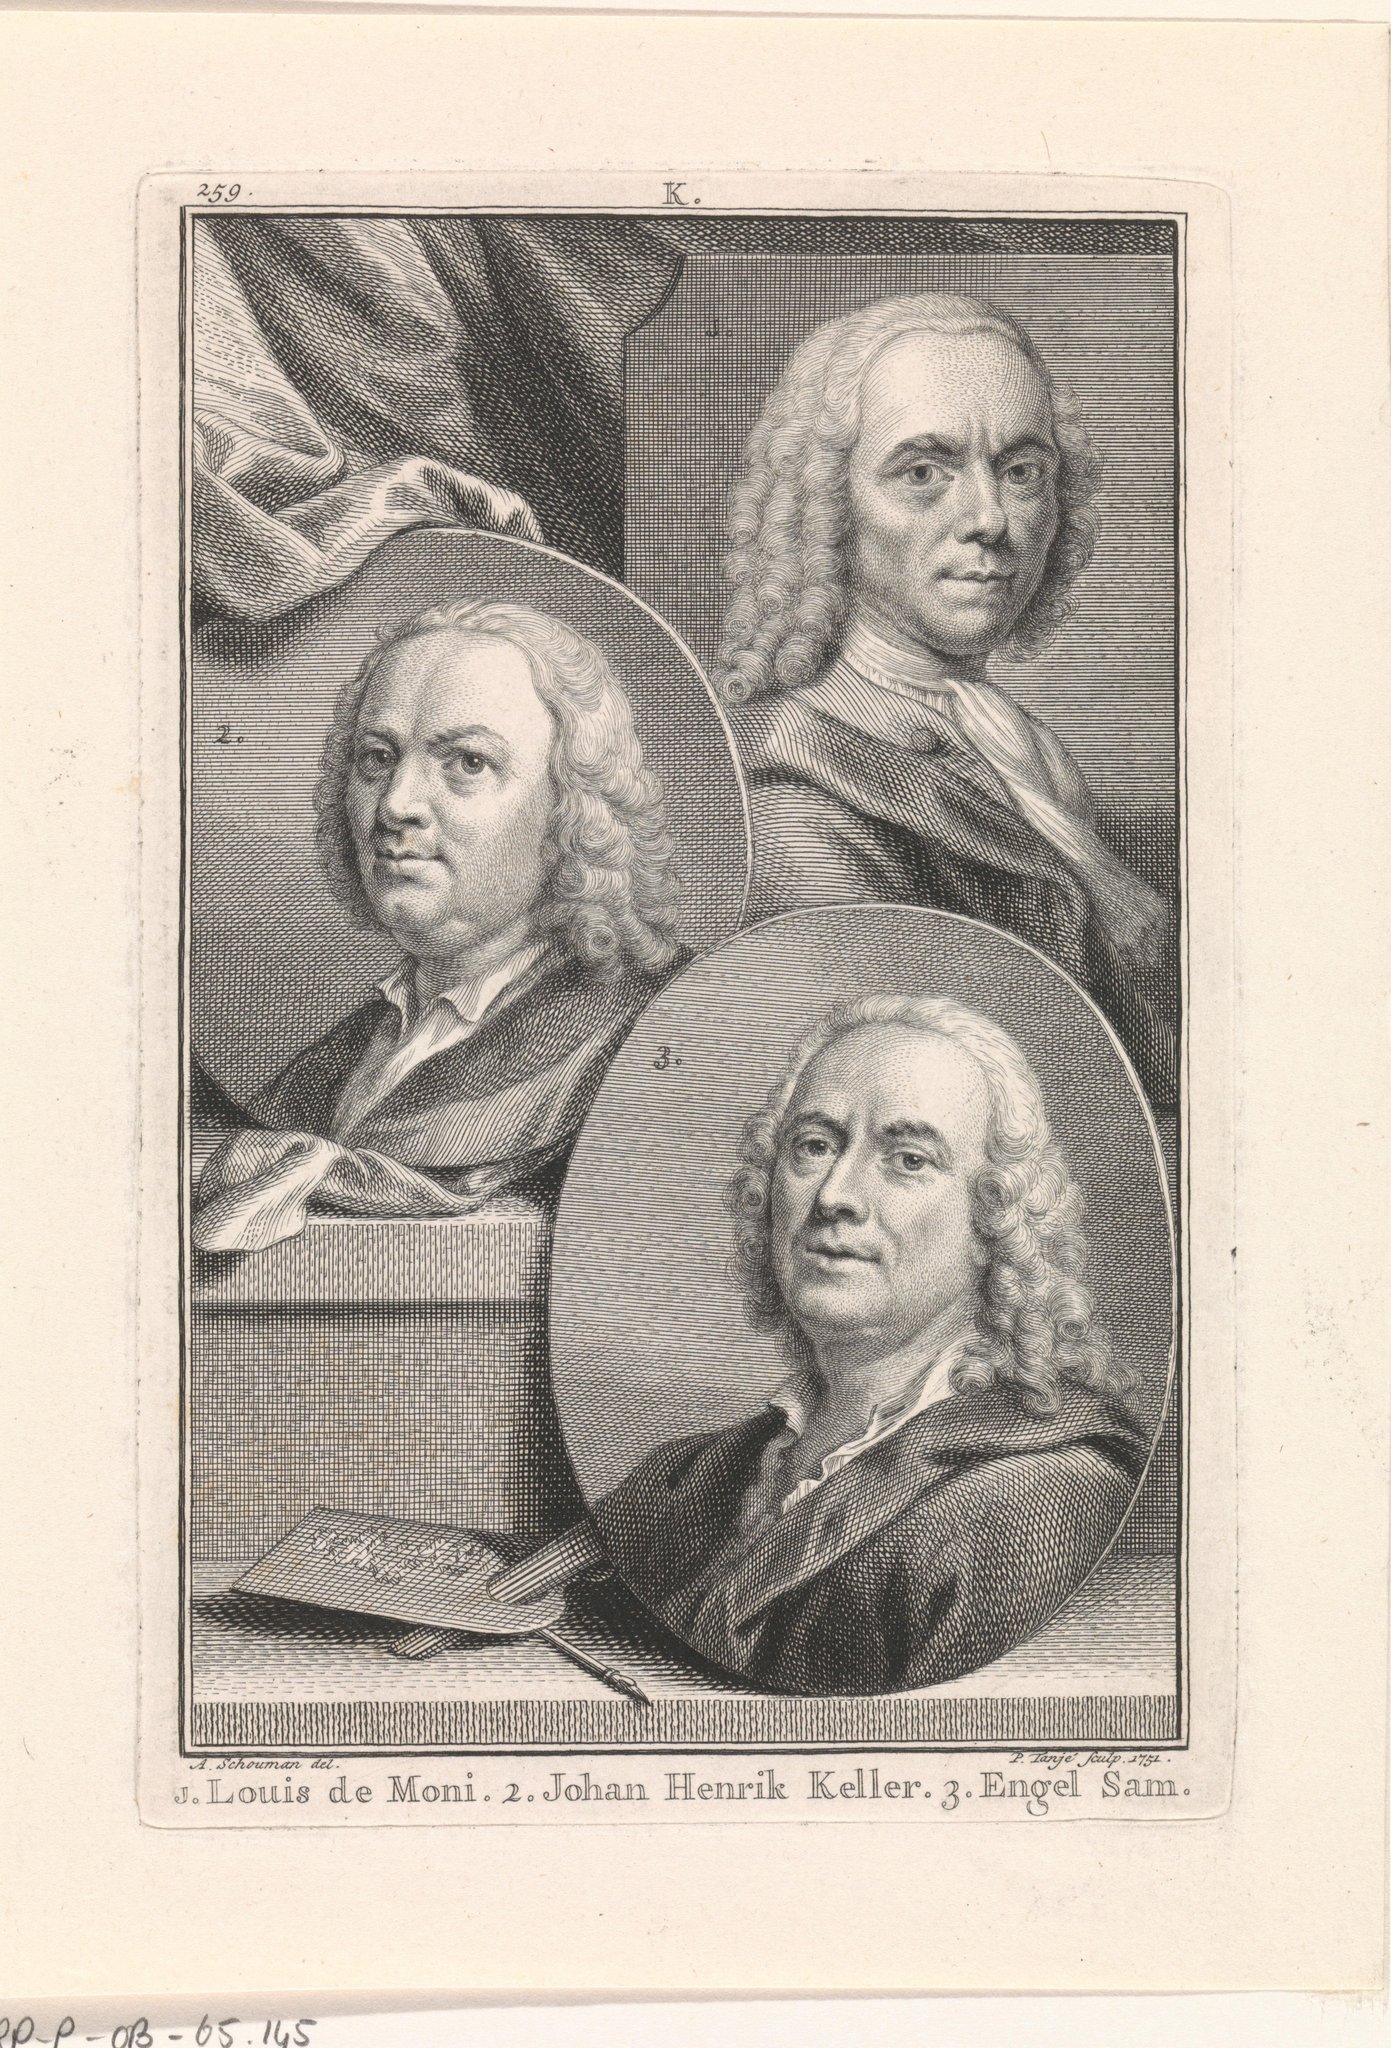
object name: print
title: Portretten van Louis de Moni, Johann Heinrich Keller en Engel Sam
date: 1751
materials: paper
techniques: engraving, etching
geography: amsterdam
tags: leiden, louis de moni, rotterdam, engel sam, the hague, painter, draughtsman, johann heinrich keller (ii), tools, implements of painter, portrait, self-portrait of artist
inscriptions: collector's mark: Lugt 240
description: Drie genummerde portretten van de schilders Louis de Moni, Johann Heinrich Keller en Engel Sam. Linksonder een palet en penselen. Midden boven: K.